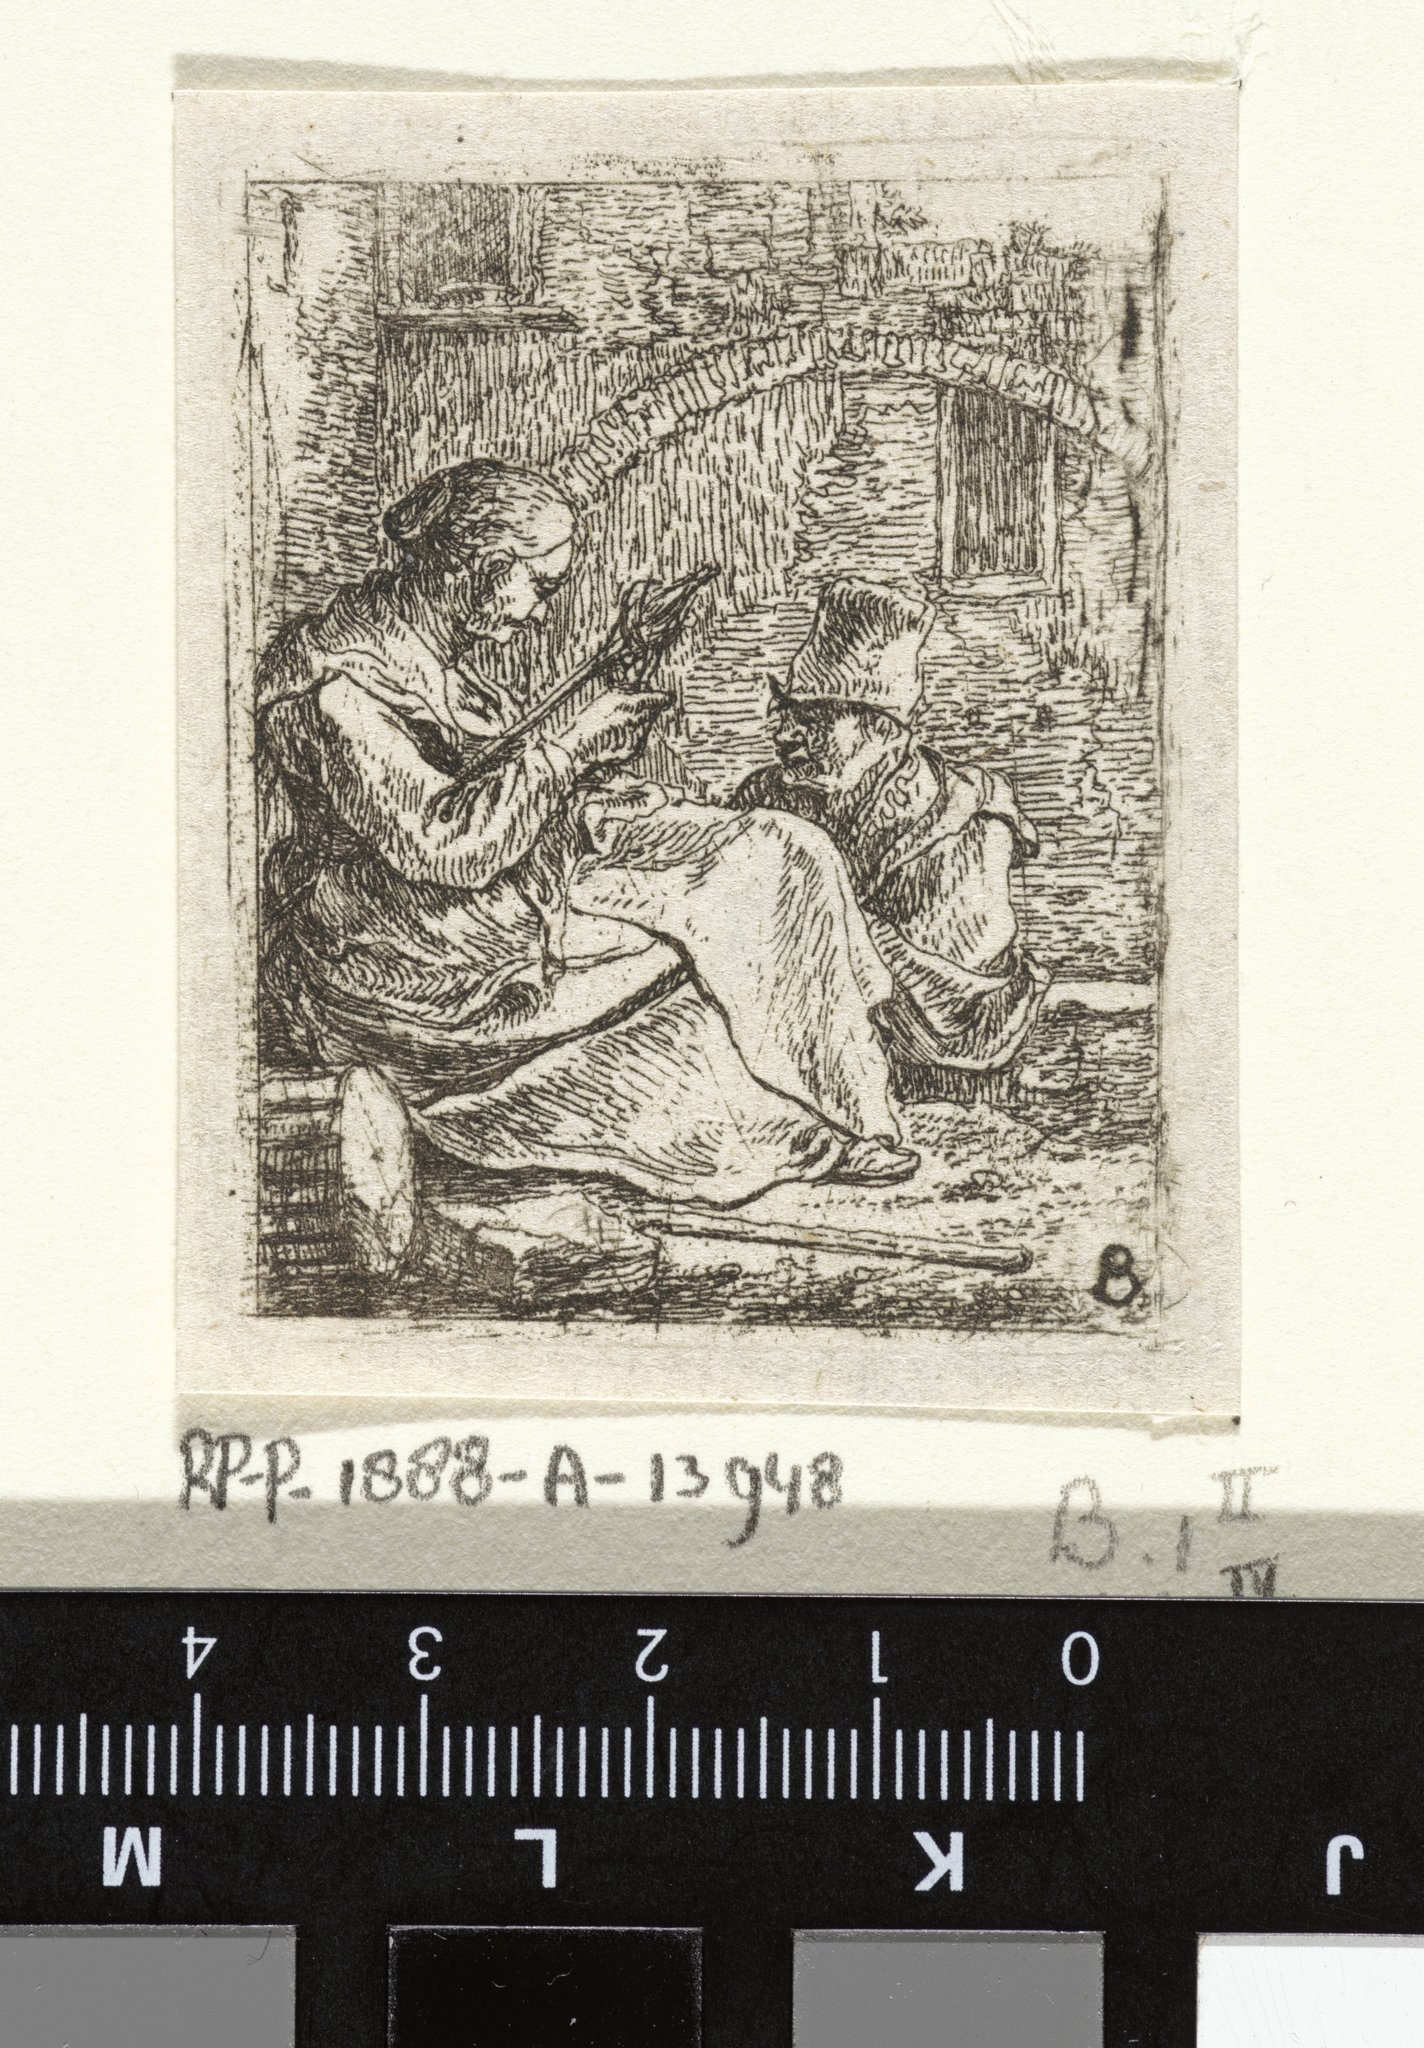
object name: print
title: Spinster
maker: thomas wijck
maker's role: draughtsman, painter, print maker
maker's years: 1616-1677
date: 1626-1677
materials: paper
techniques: drypoint, etching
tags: spinning (manufacture of yarn)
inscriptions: collector's mark: Lugt 2228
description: Een spinster aan het werk voor een huis. Op de achtergrond een man met een hoed. Rechtsonder genummerd: 8.